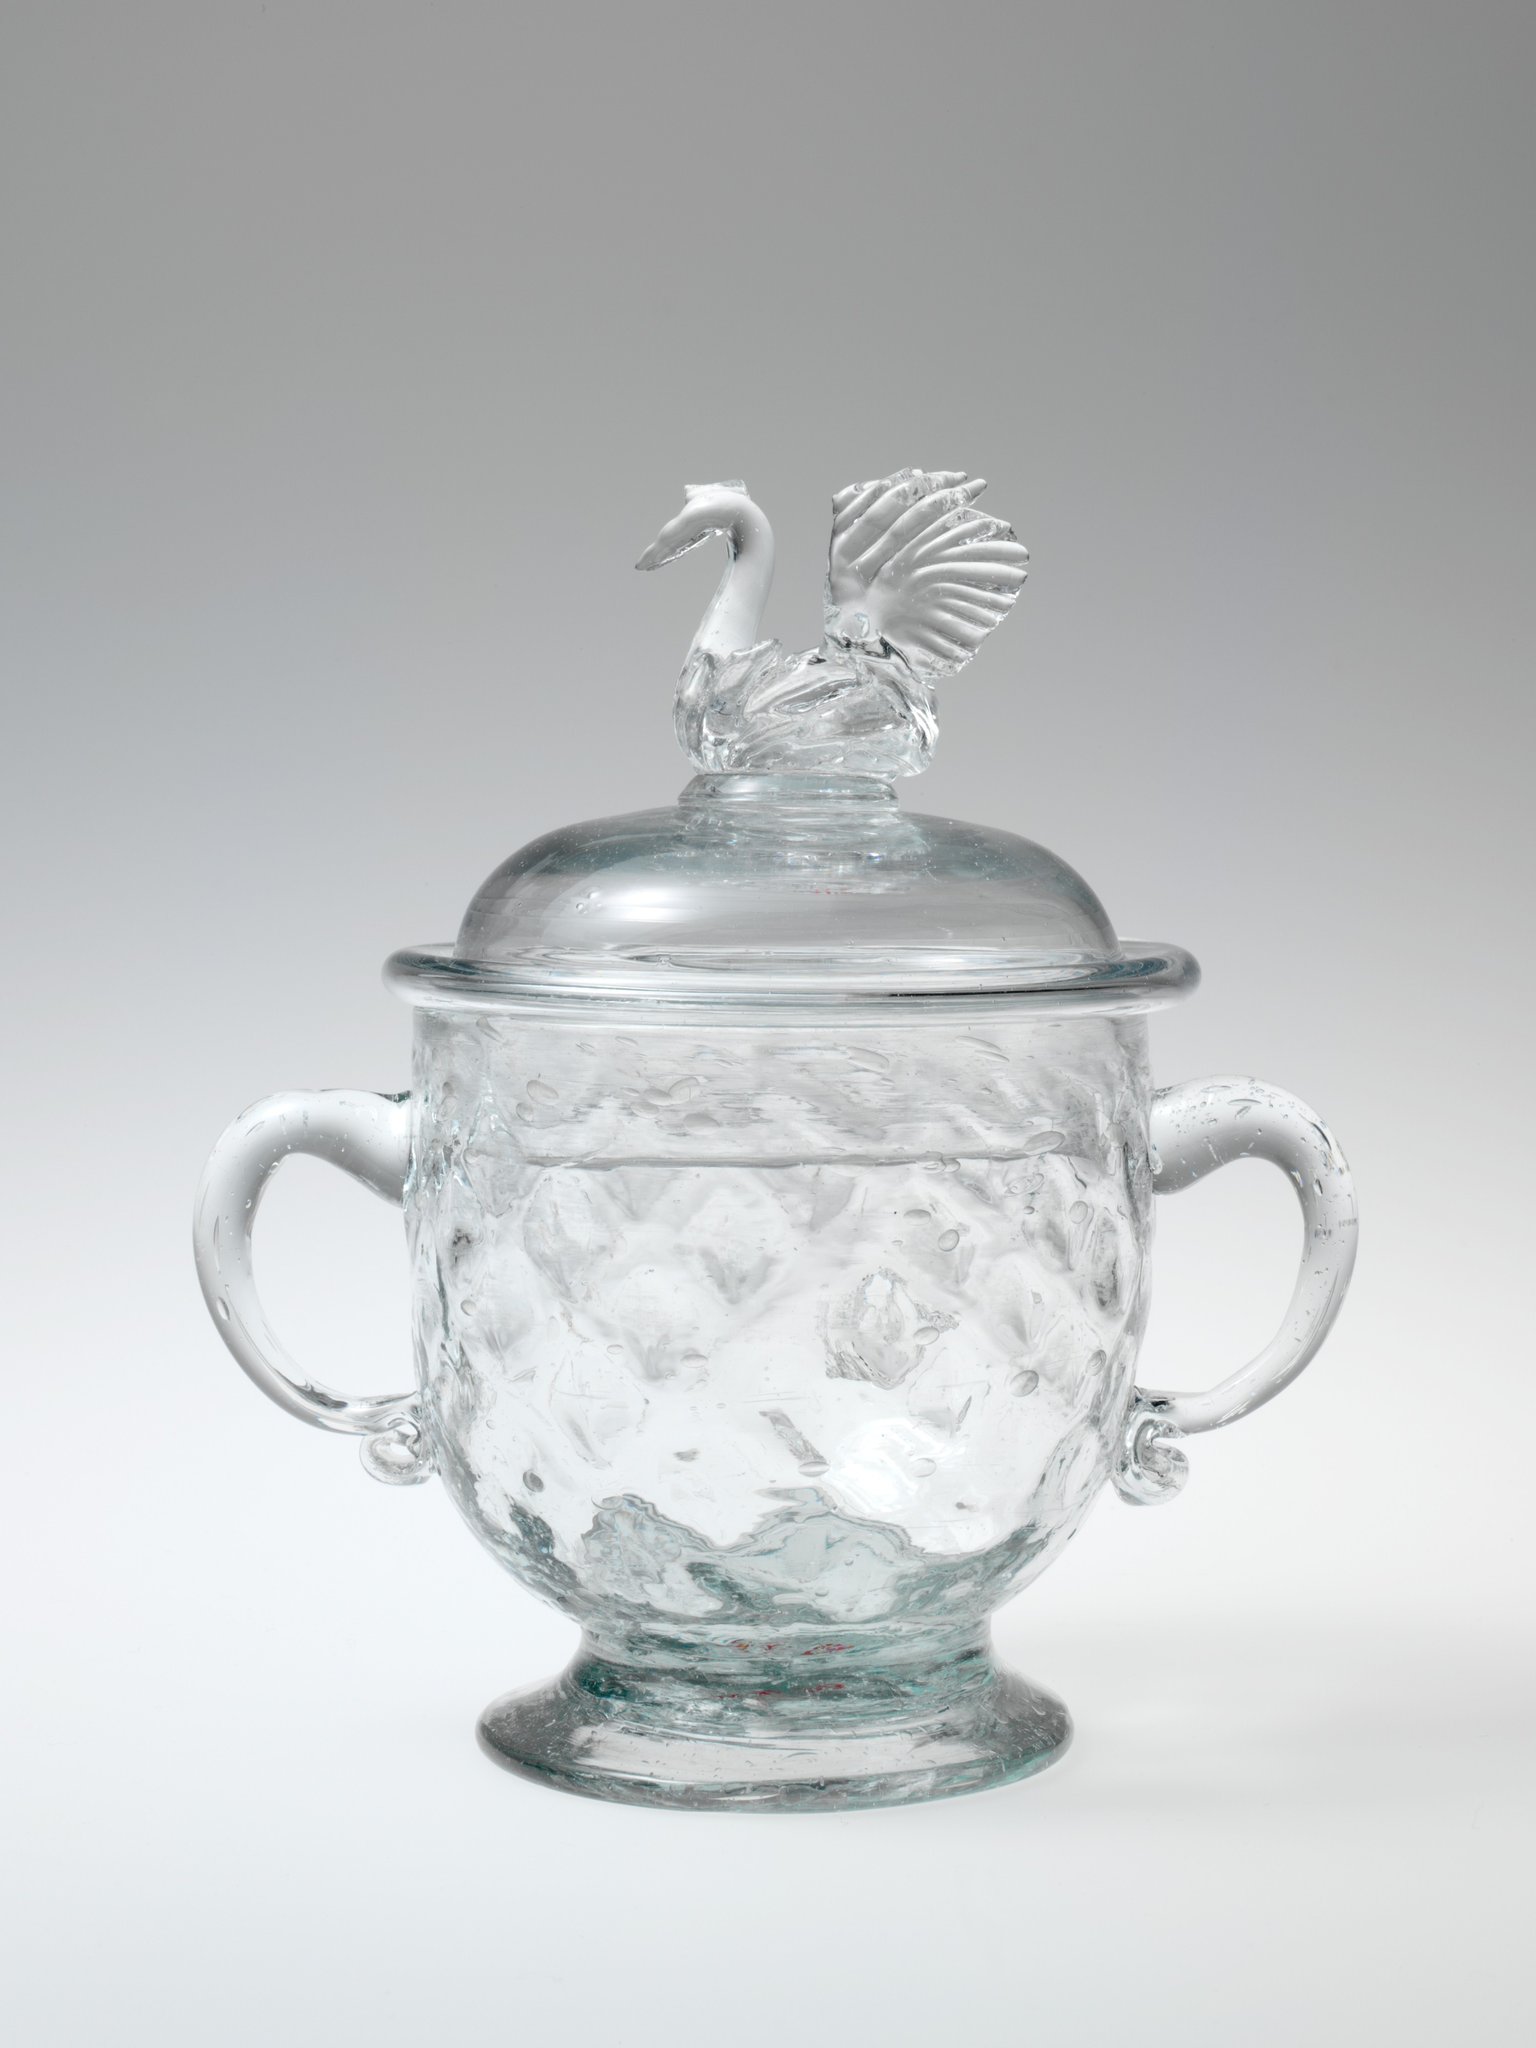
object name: cover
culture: american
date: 1770-1800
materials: glass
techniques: glassblowing, molding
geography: united states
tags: swans